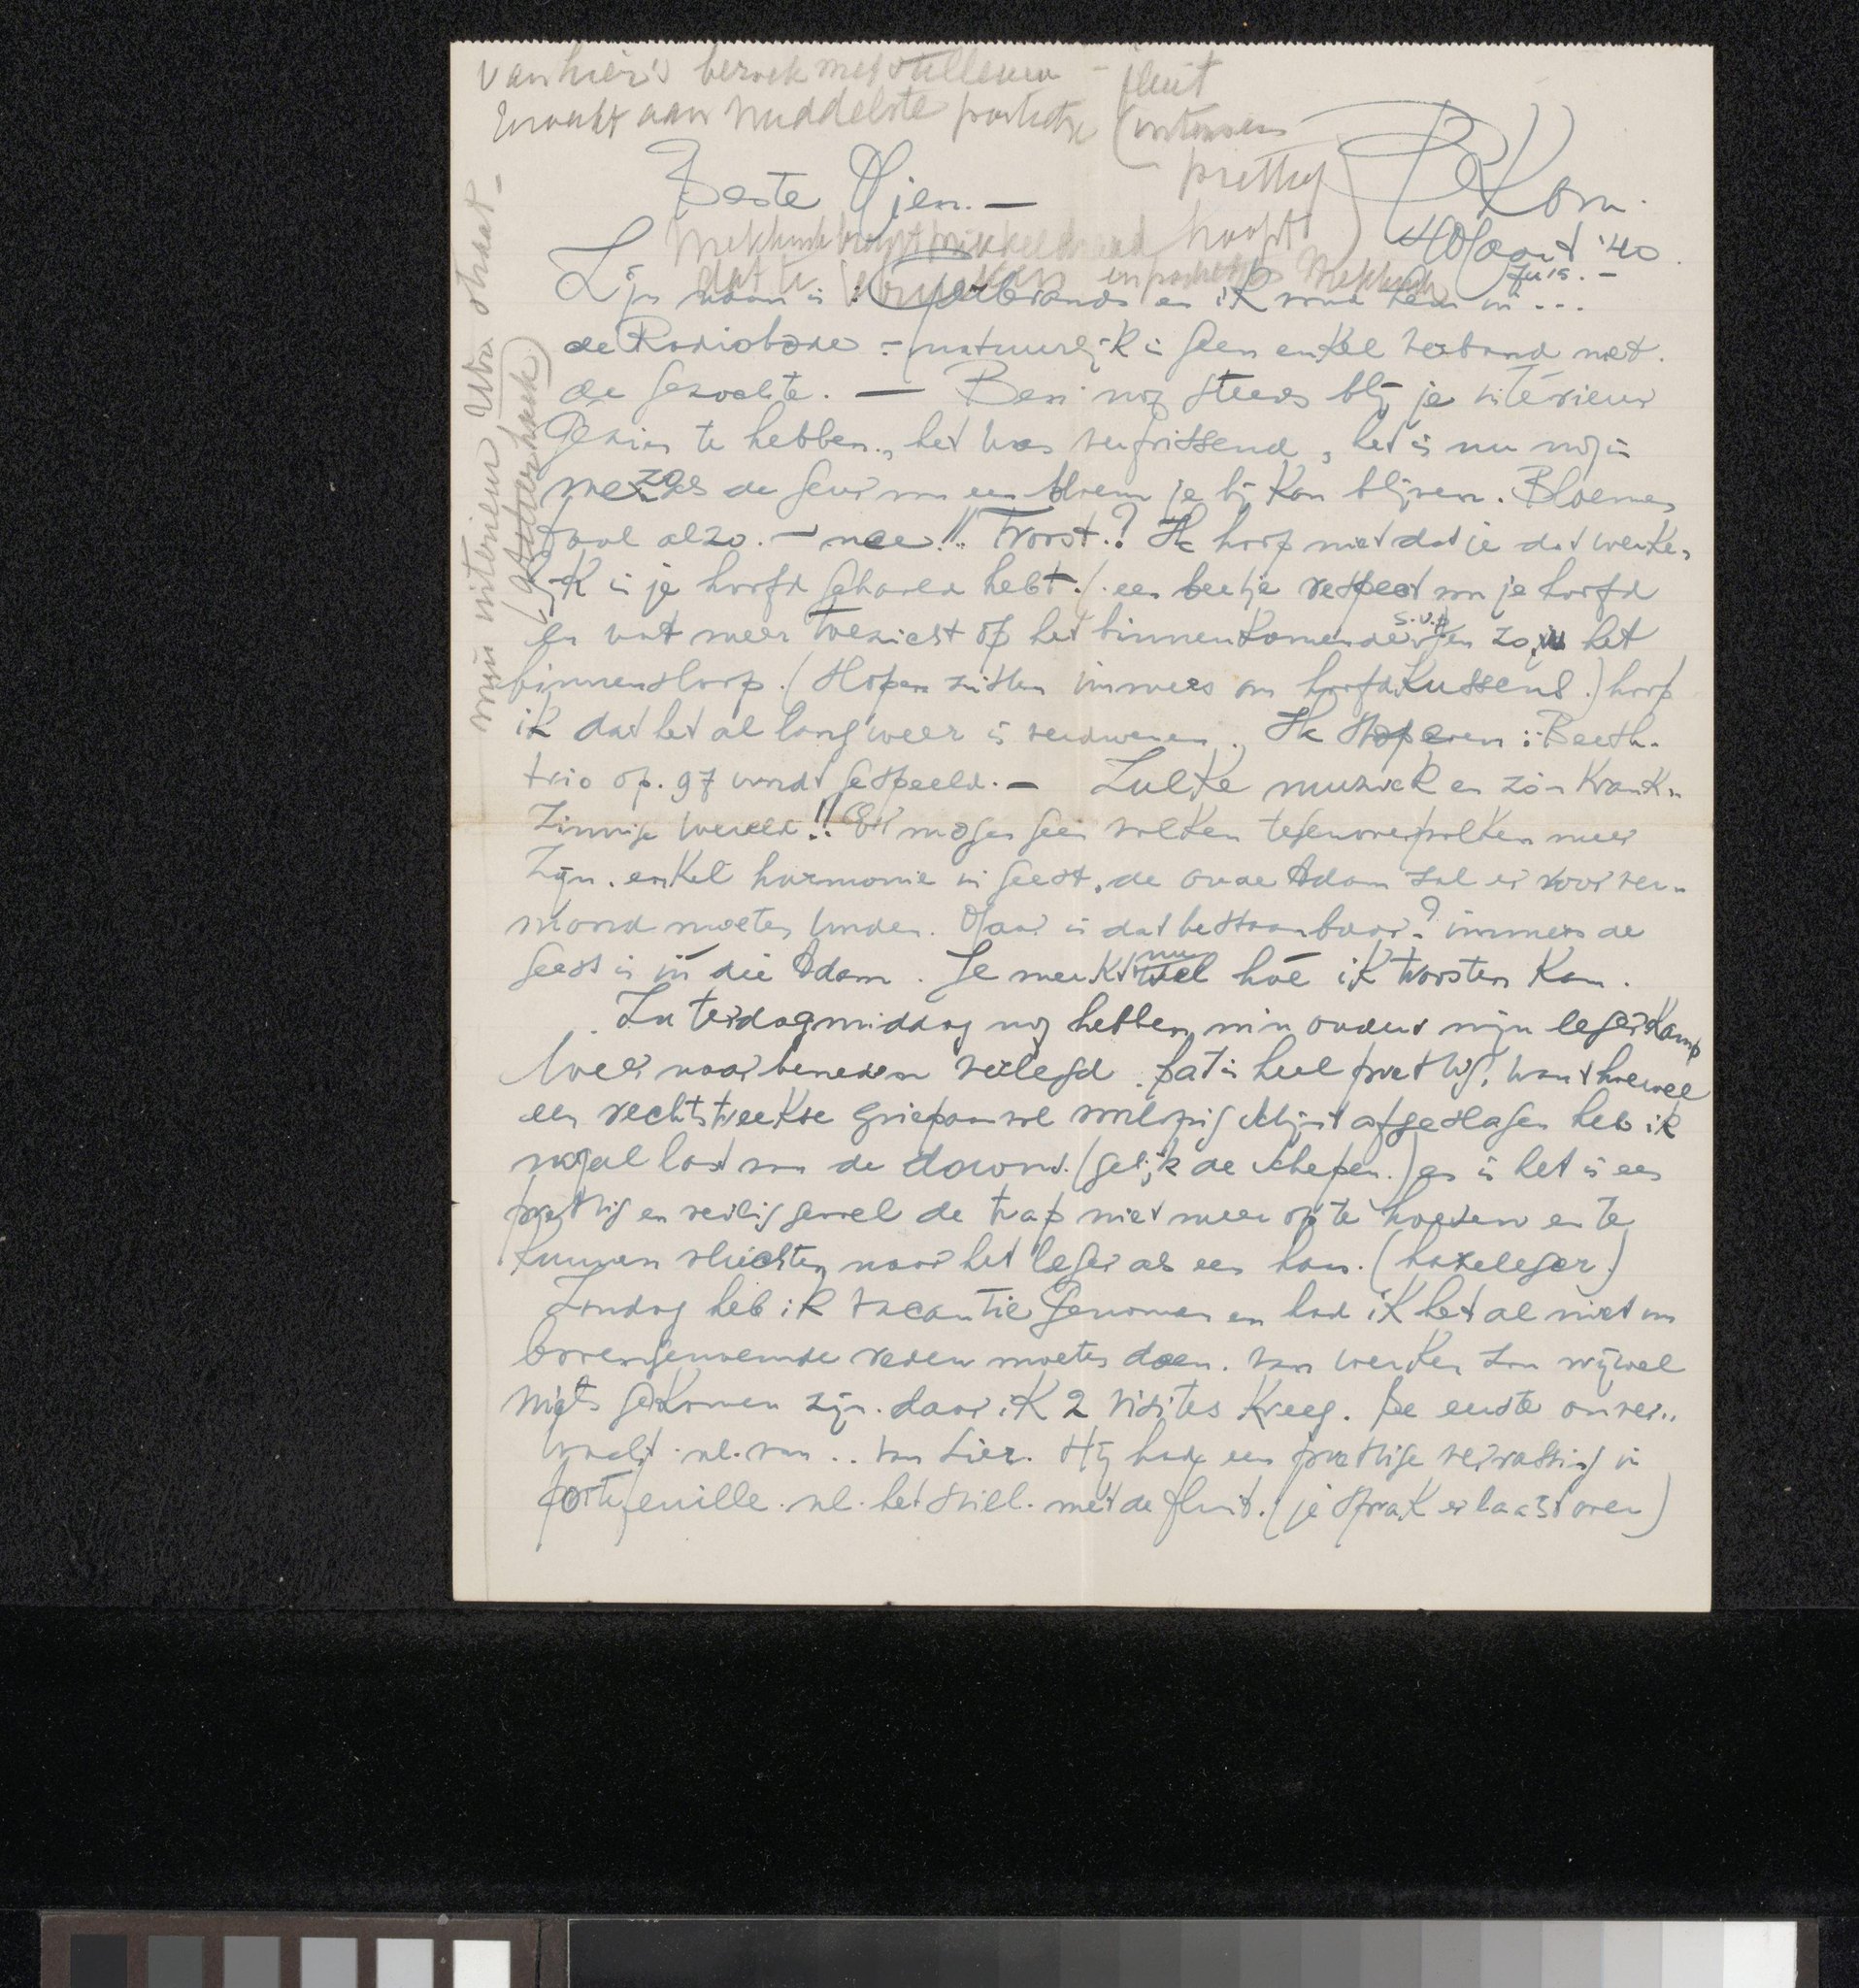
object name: letter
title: Brief aan Mien Cambier van Nooten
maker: dick ket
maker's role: draughtsman, print maker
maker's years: 1902-1940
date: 1940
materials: ink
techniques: pen, writing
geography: bennekom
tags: the hague, arnhem, mien cambier van nooten, amsterdam, paris, wim oepts, print maker, kasper niehaus, draughtsman, johan mekkink, chris huidekooper, passions, emotions, affections, music, painting (including book-illumination, miniature-painting), exhibition ~ art, diseases, historical persons (portraits and scenes from the life)